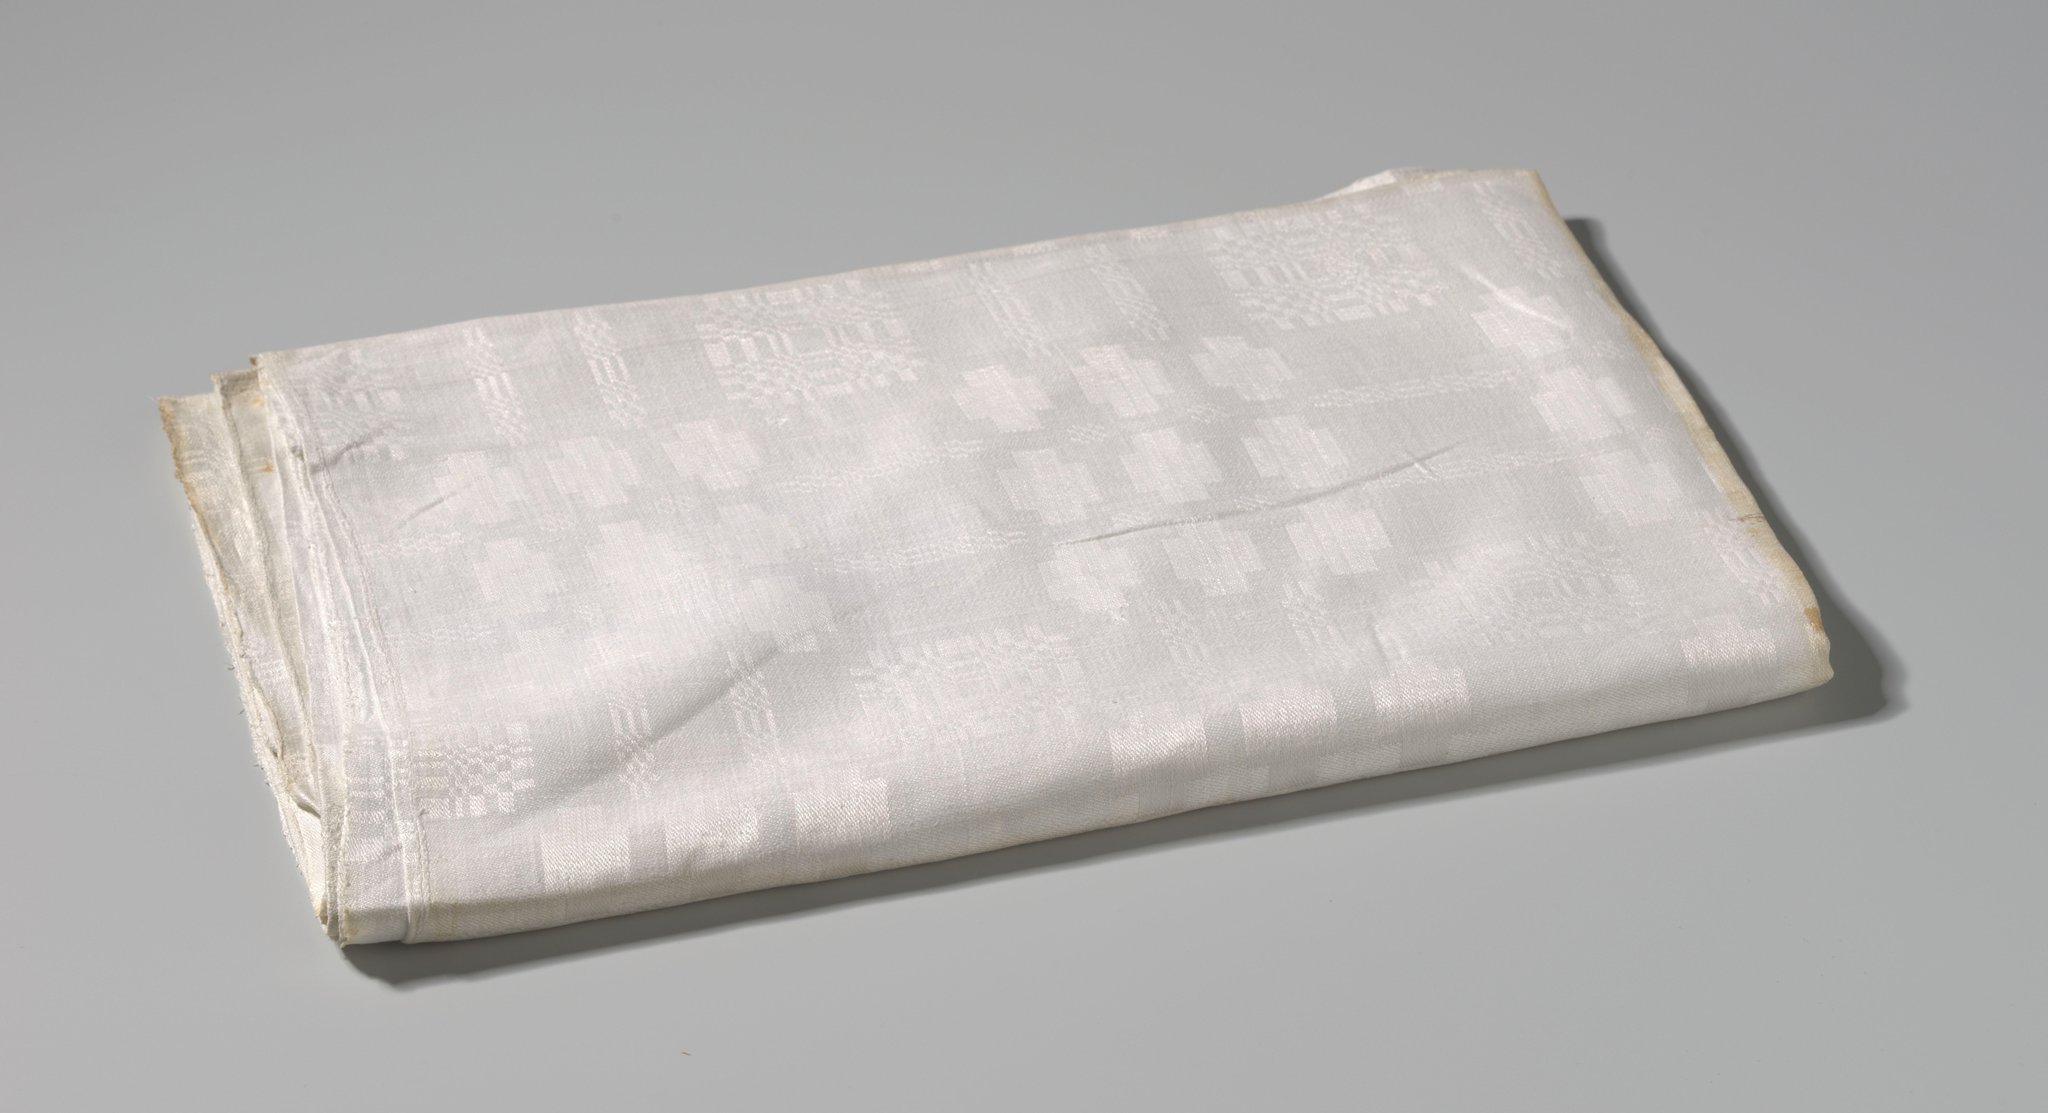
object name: tablecloth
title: Tafellaken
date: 1725-1775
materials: linen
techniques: peeled fabric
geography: northern netherlands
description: Wit linnen tafellaken met een pellen patroon . Merk kroon G 4.